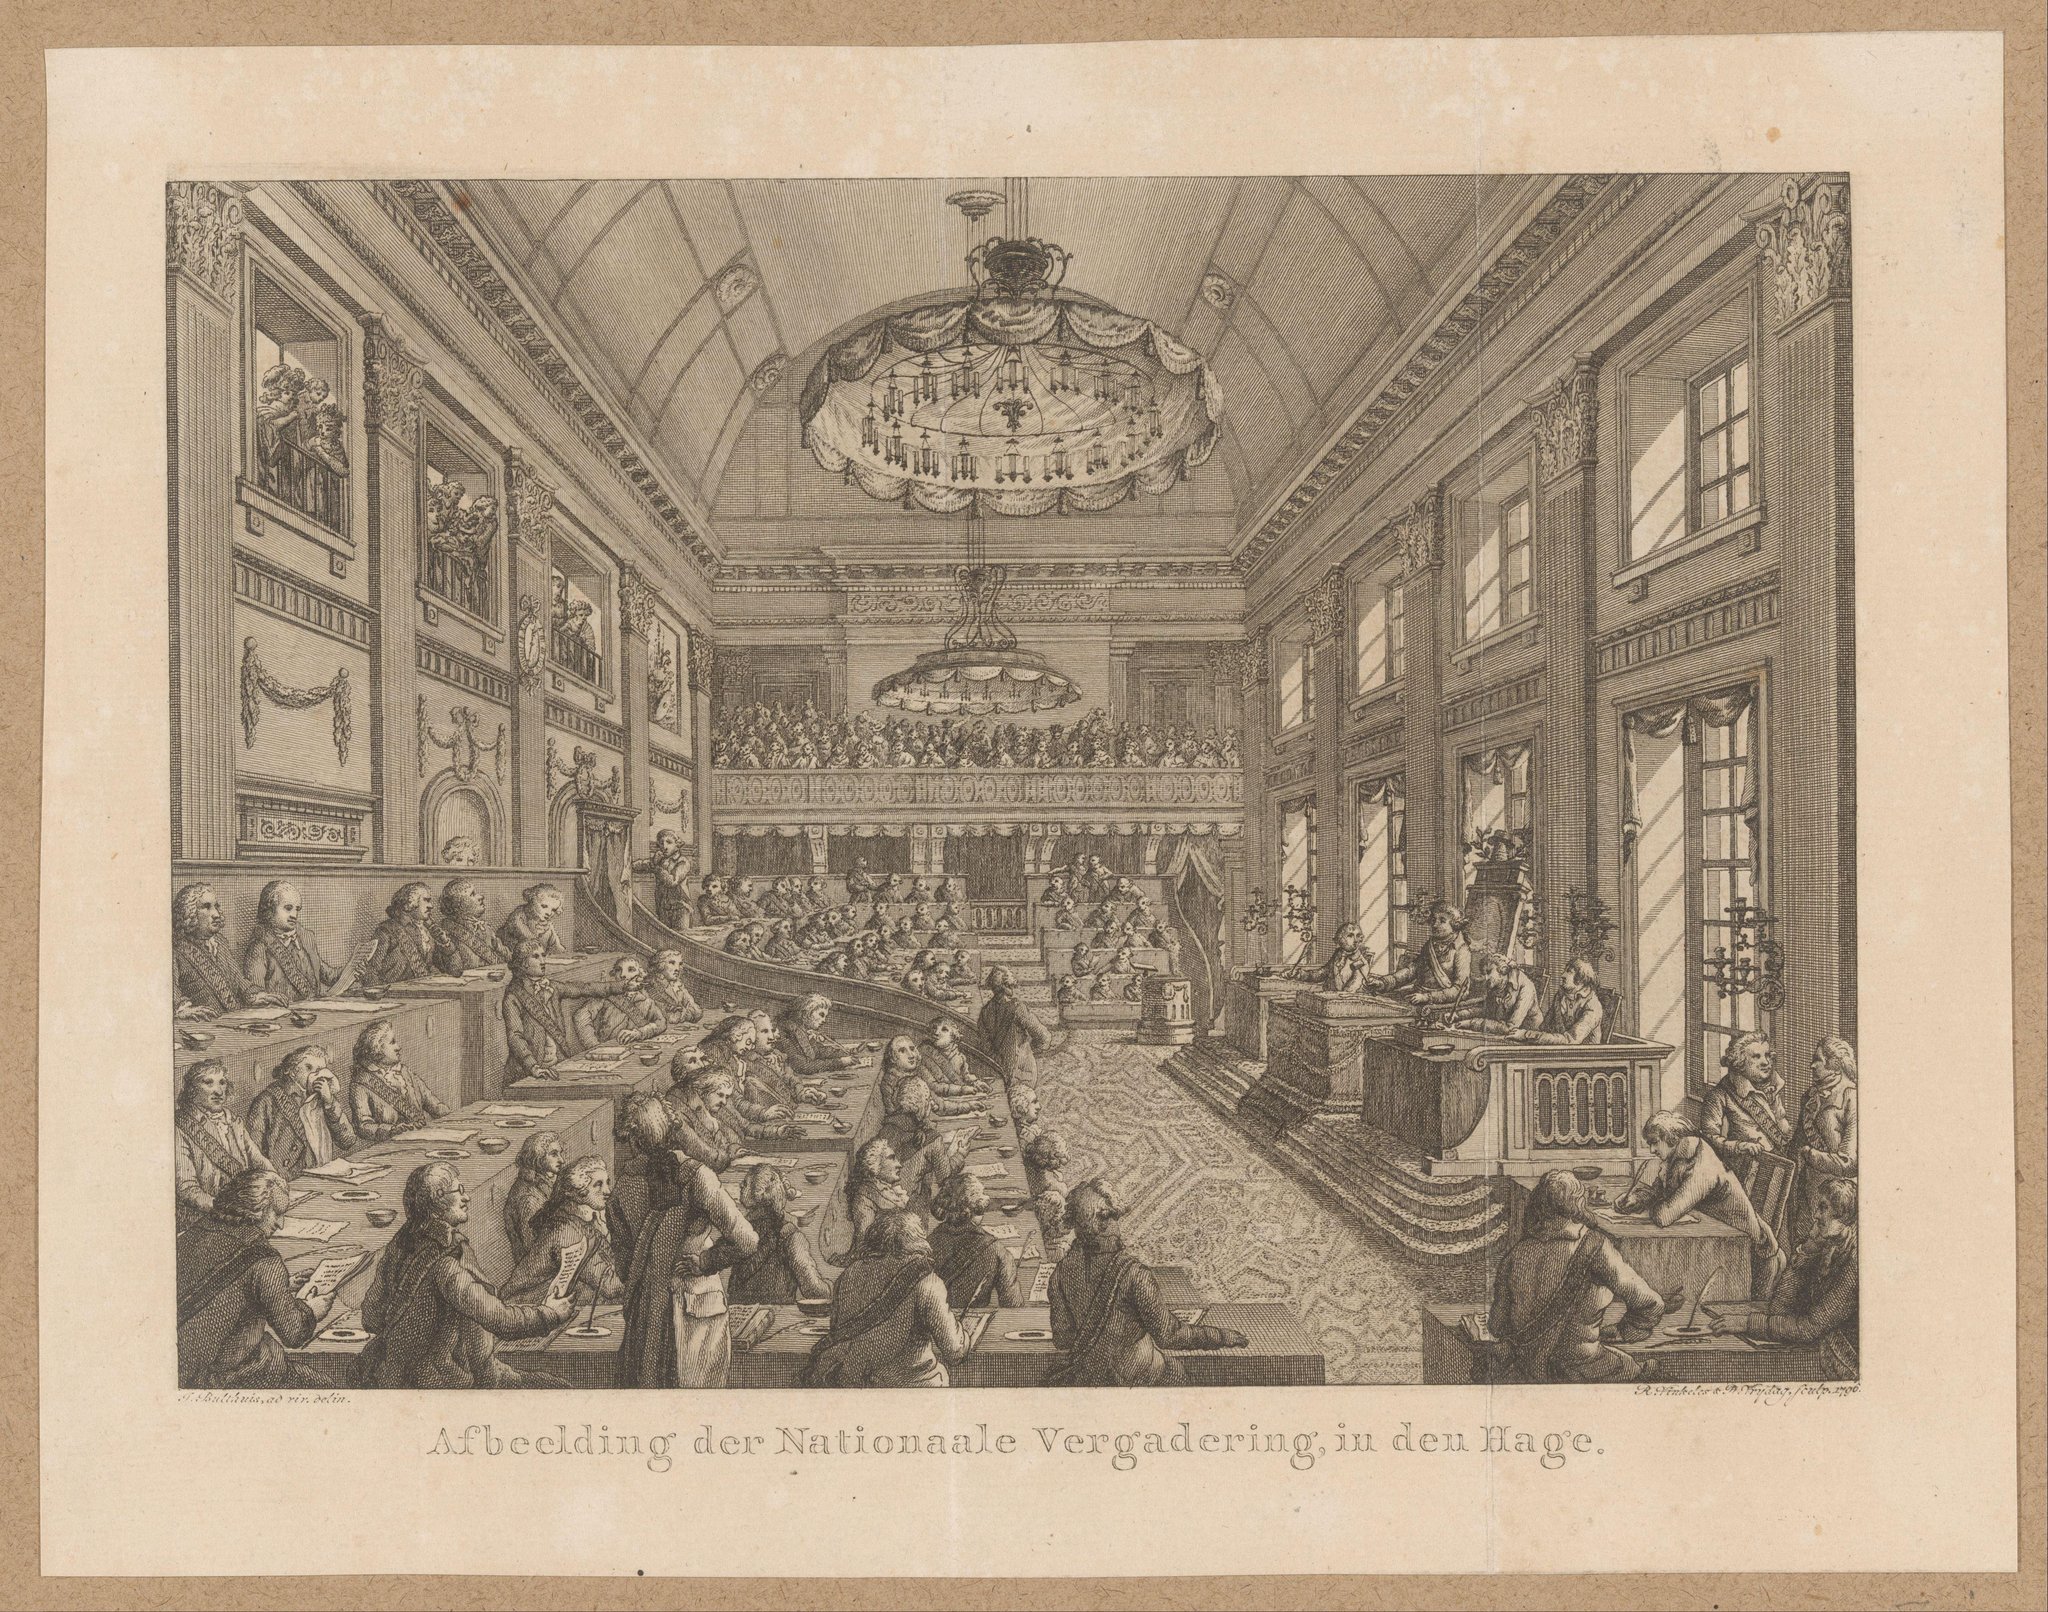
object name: print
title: Eerste Nationale Vergadering in Den Haag, 1796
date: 1796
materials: paper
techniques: etching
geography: amsterdam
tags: revolutionary government, lower house, parliament, chamber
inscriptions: date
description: Zitting van de Eerste Nationale Vergadering in Den Haag, van 1 maart 1796 tot 31 augustus 1797. Gezicht in de vergaderzaal (voormalige danszaal van het Stadhouderlijke Paleis) met de leden, allen met lint als representant. Rechts spreek de voorzitter de vergadering toe. Op de achtergrond de volle publieke tribune.